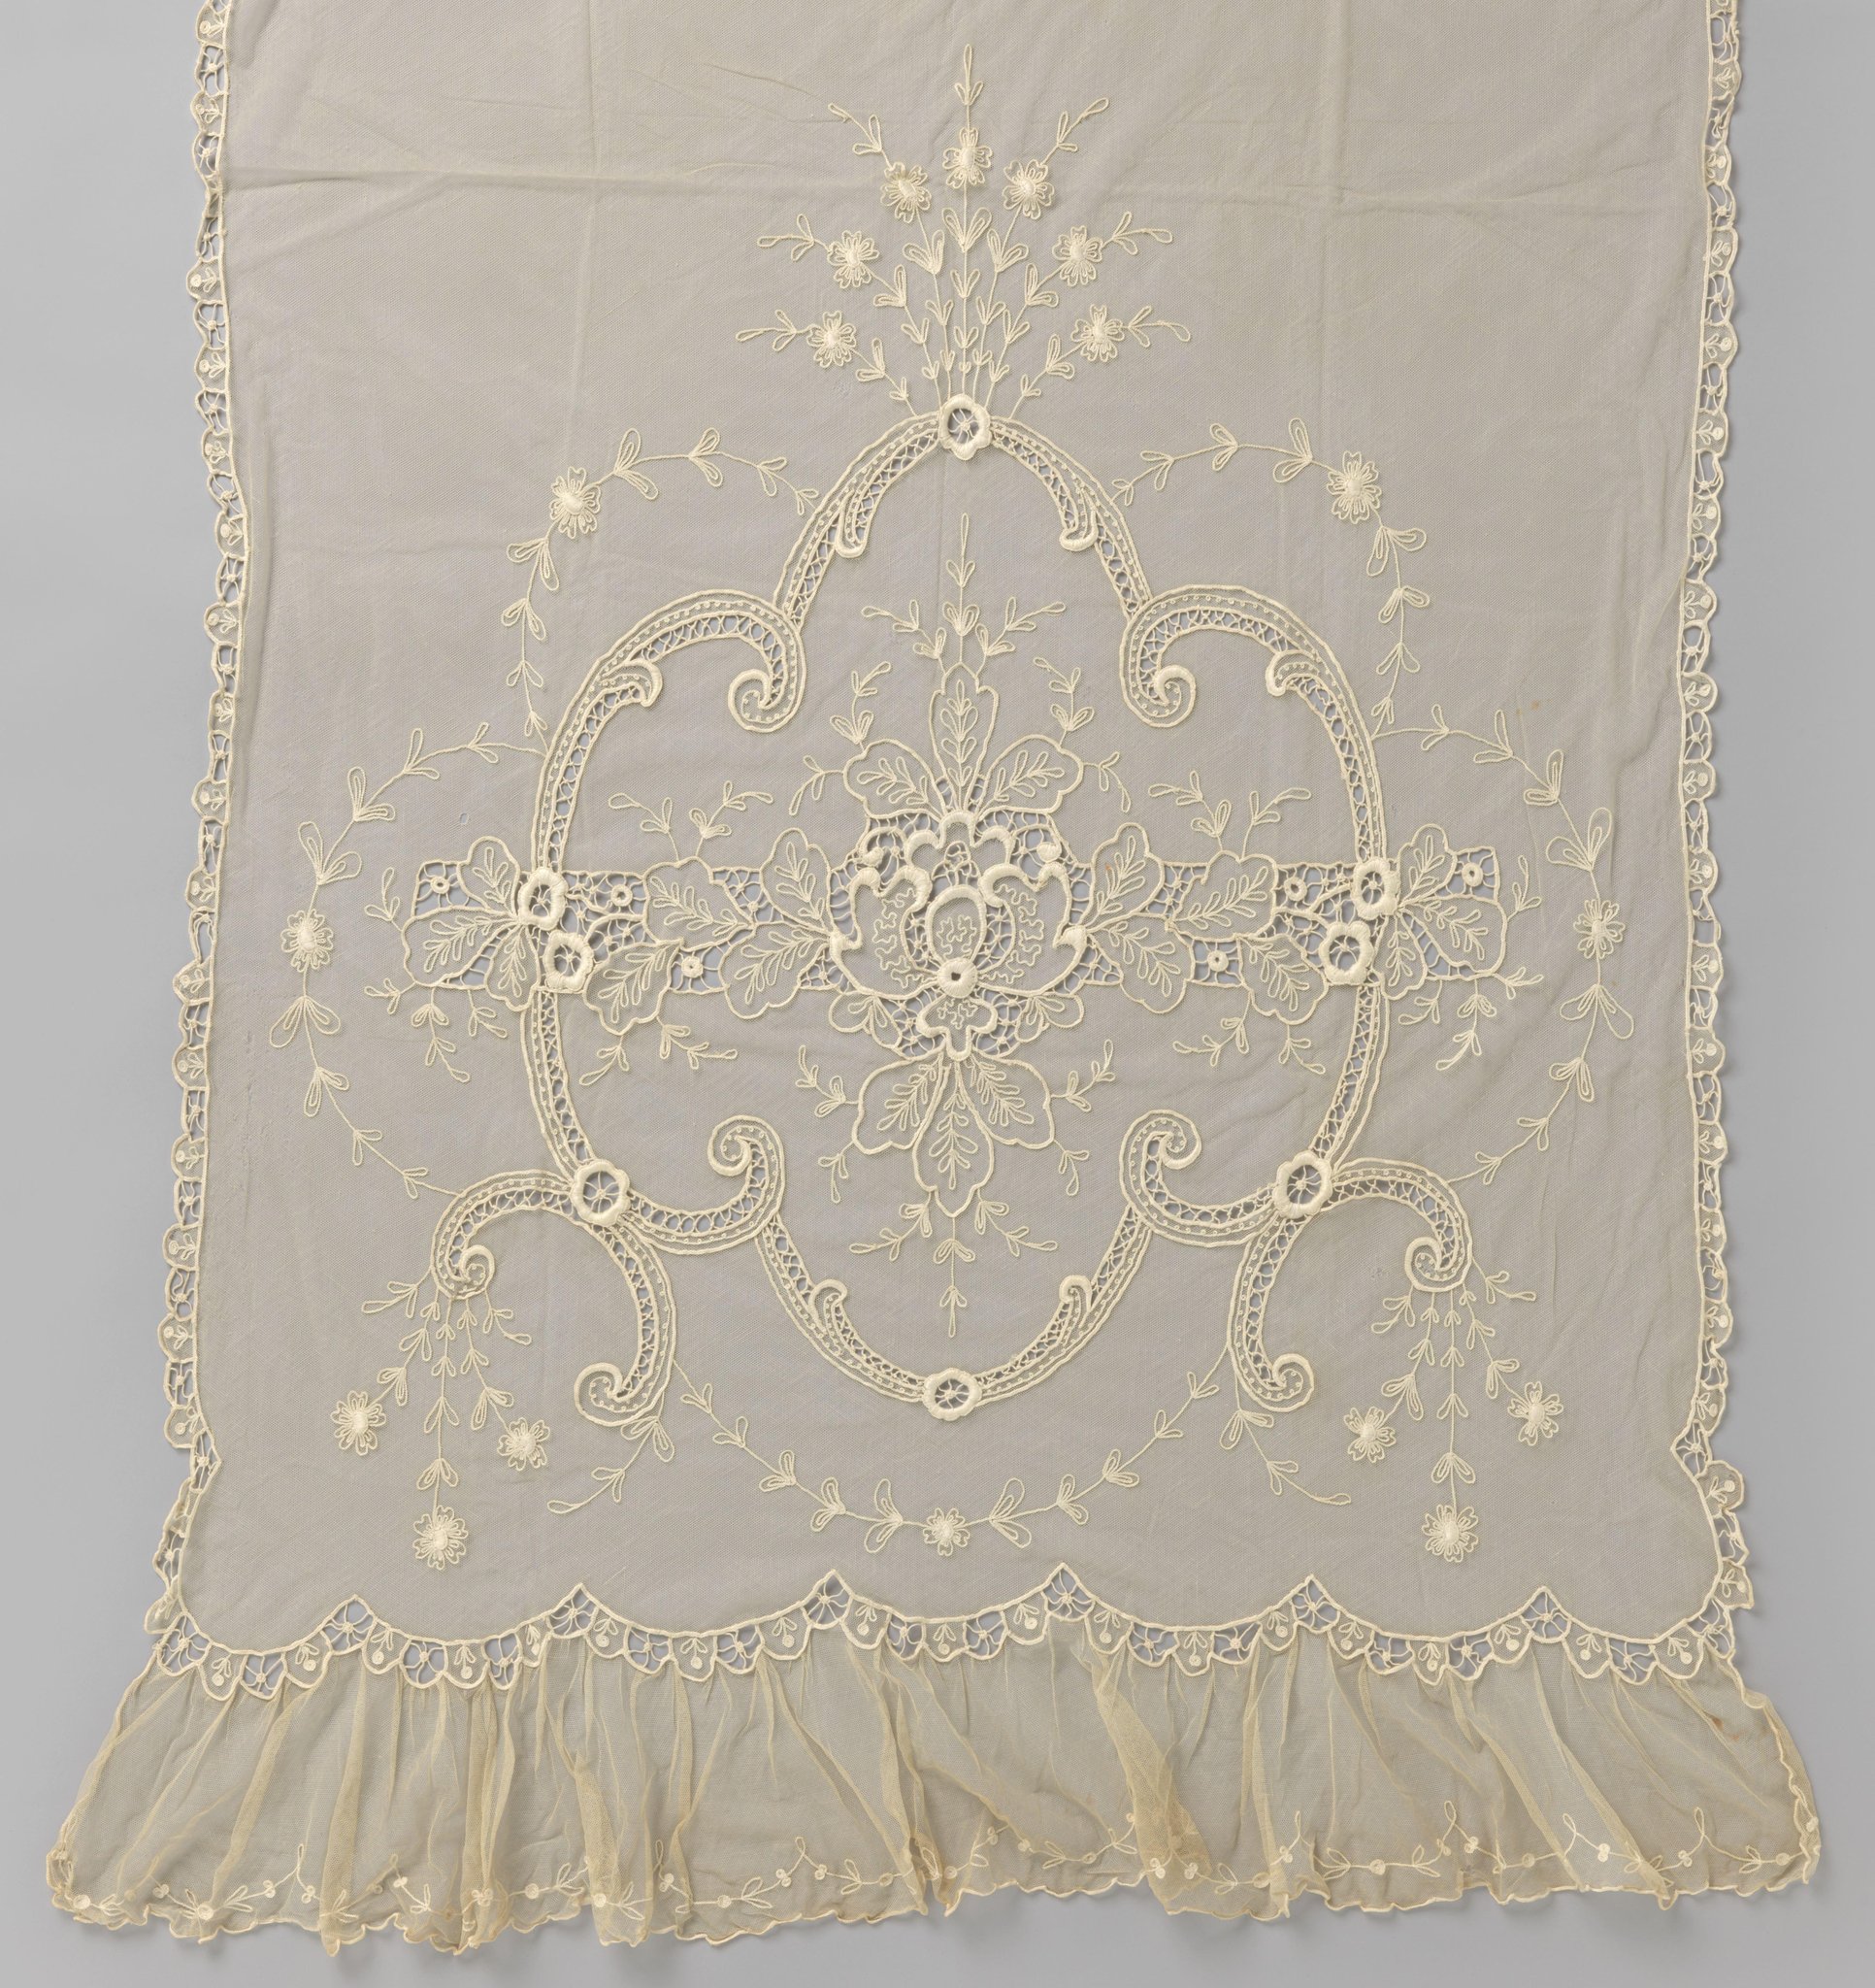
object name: bed curtain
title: Gordijn van een hemelbed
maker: Anonymous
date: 1890-1910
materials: fiber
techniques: embroidered, stitch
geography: scotland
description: Gordijn van een hemelbed van machinale tule in wit geborduurd met ketting- en festonsteek met opengewerkte partijen op de manier van Richelieu-borduurwerk. Bloem- en bladmotief in cartouche.